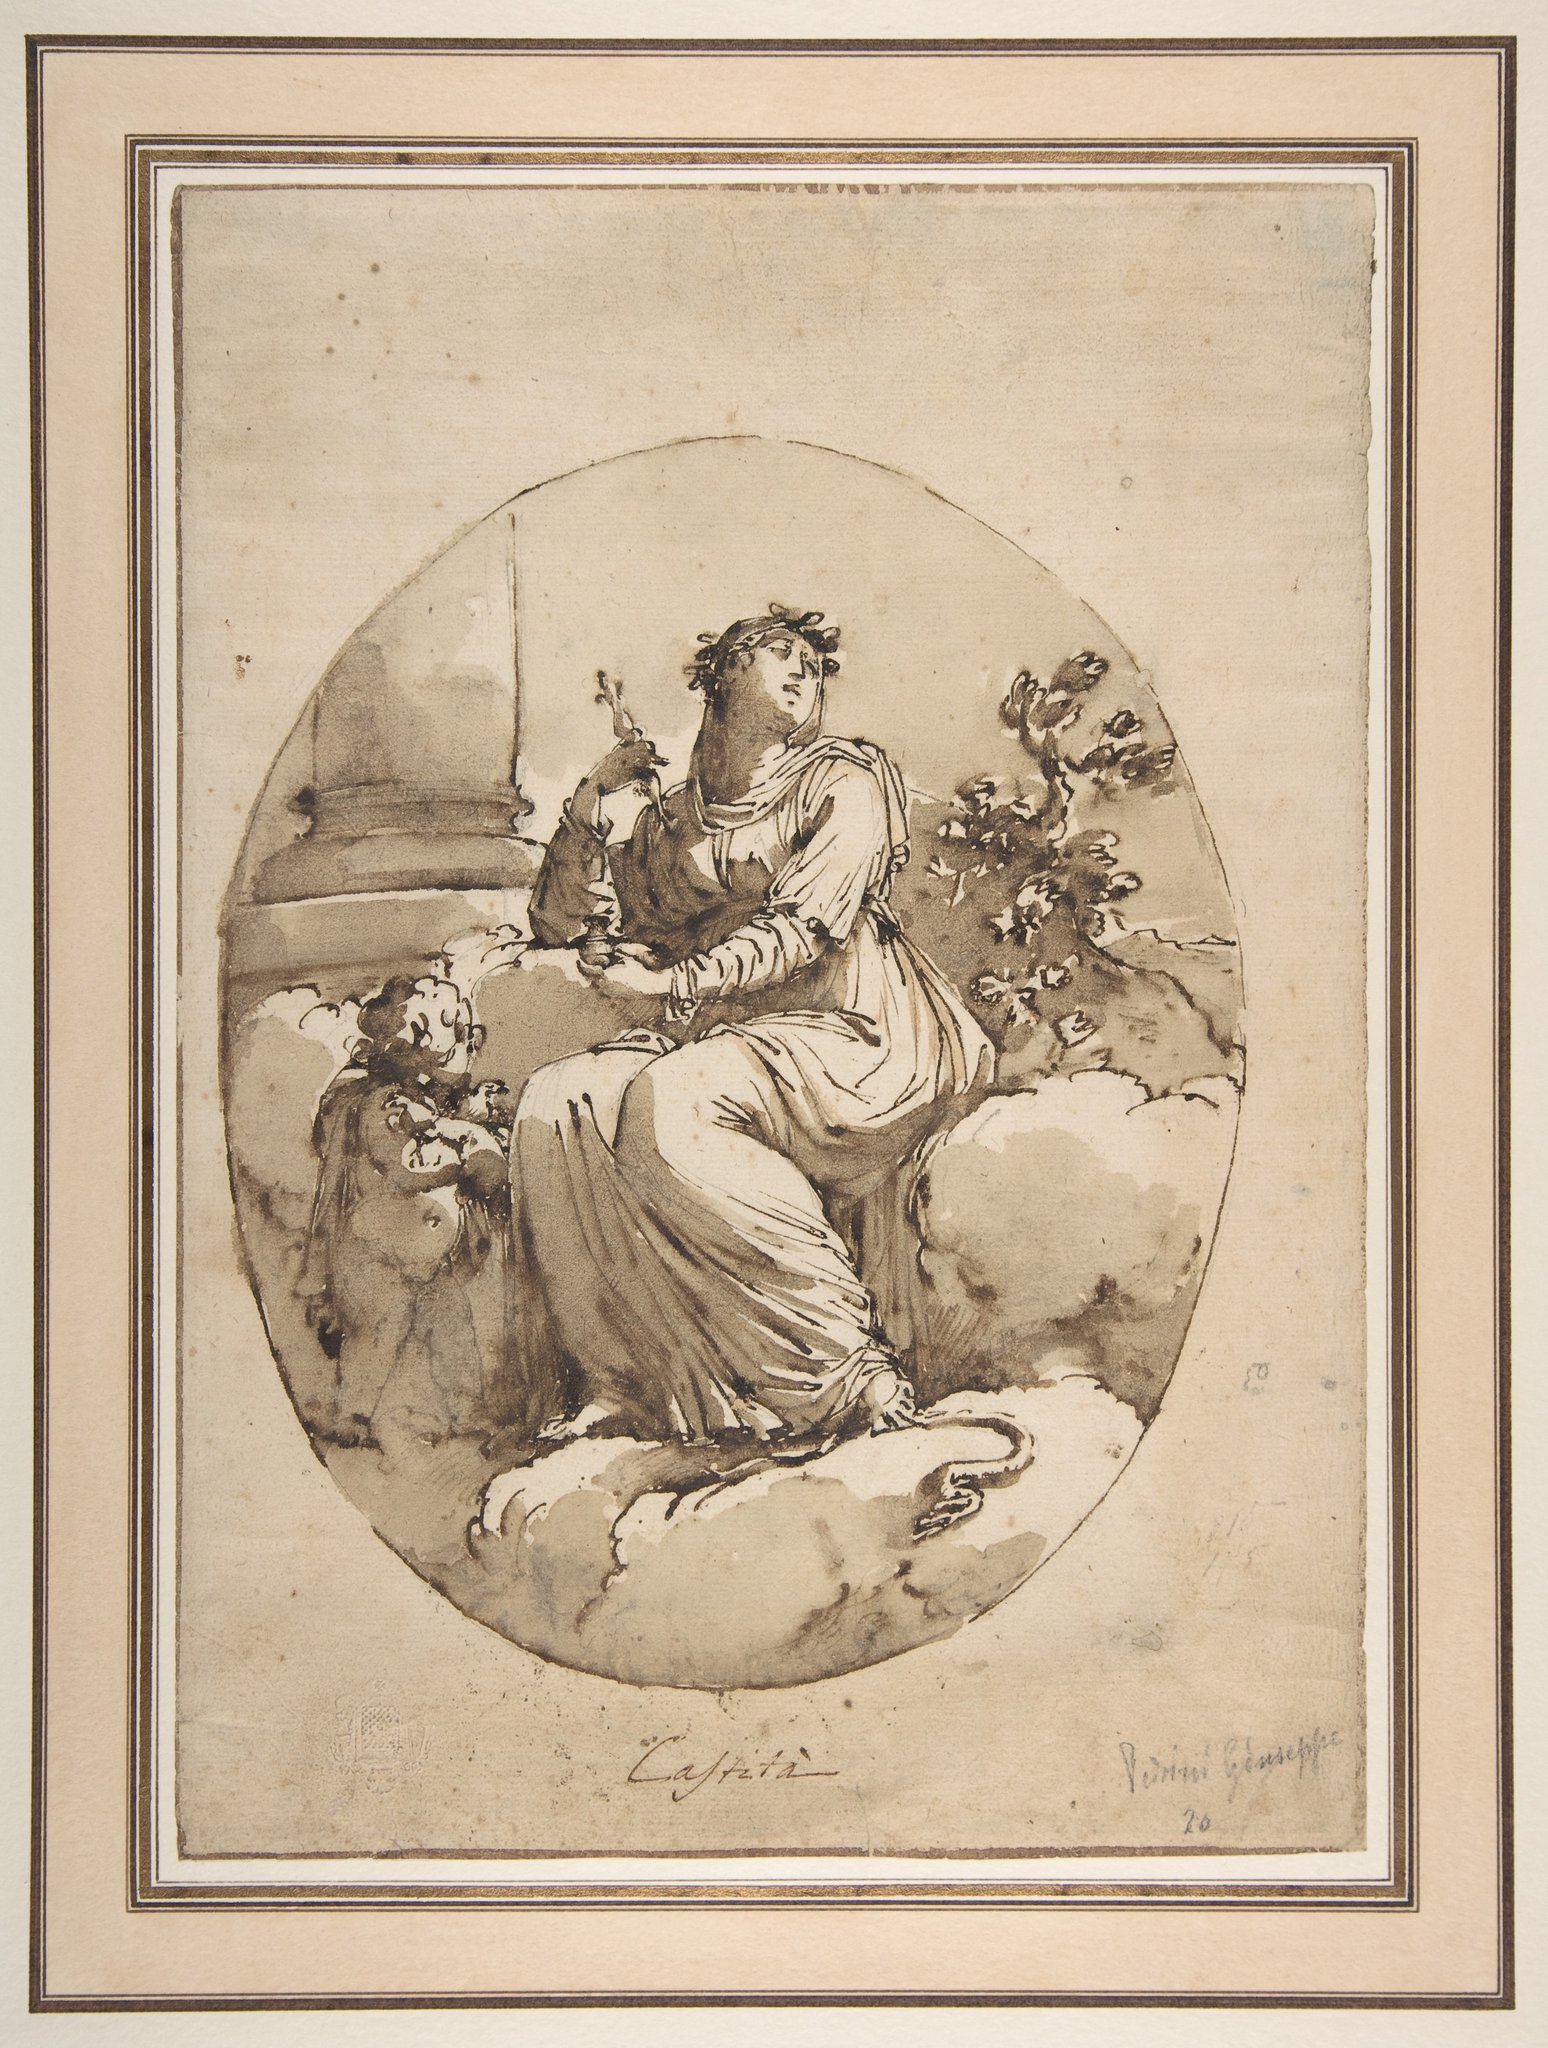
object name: drawing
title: Allegorical Figure of Chastity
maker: filippo pedrini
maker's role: artist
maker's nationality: italian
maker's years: 1763-1856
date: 1792-1816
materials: graphite, ink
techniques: brush, pen, wash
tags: children,women